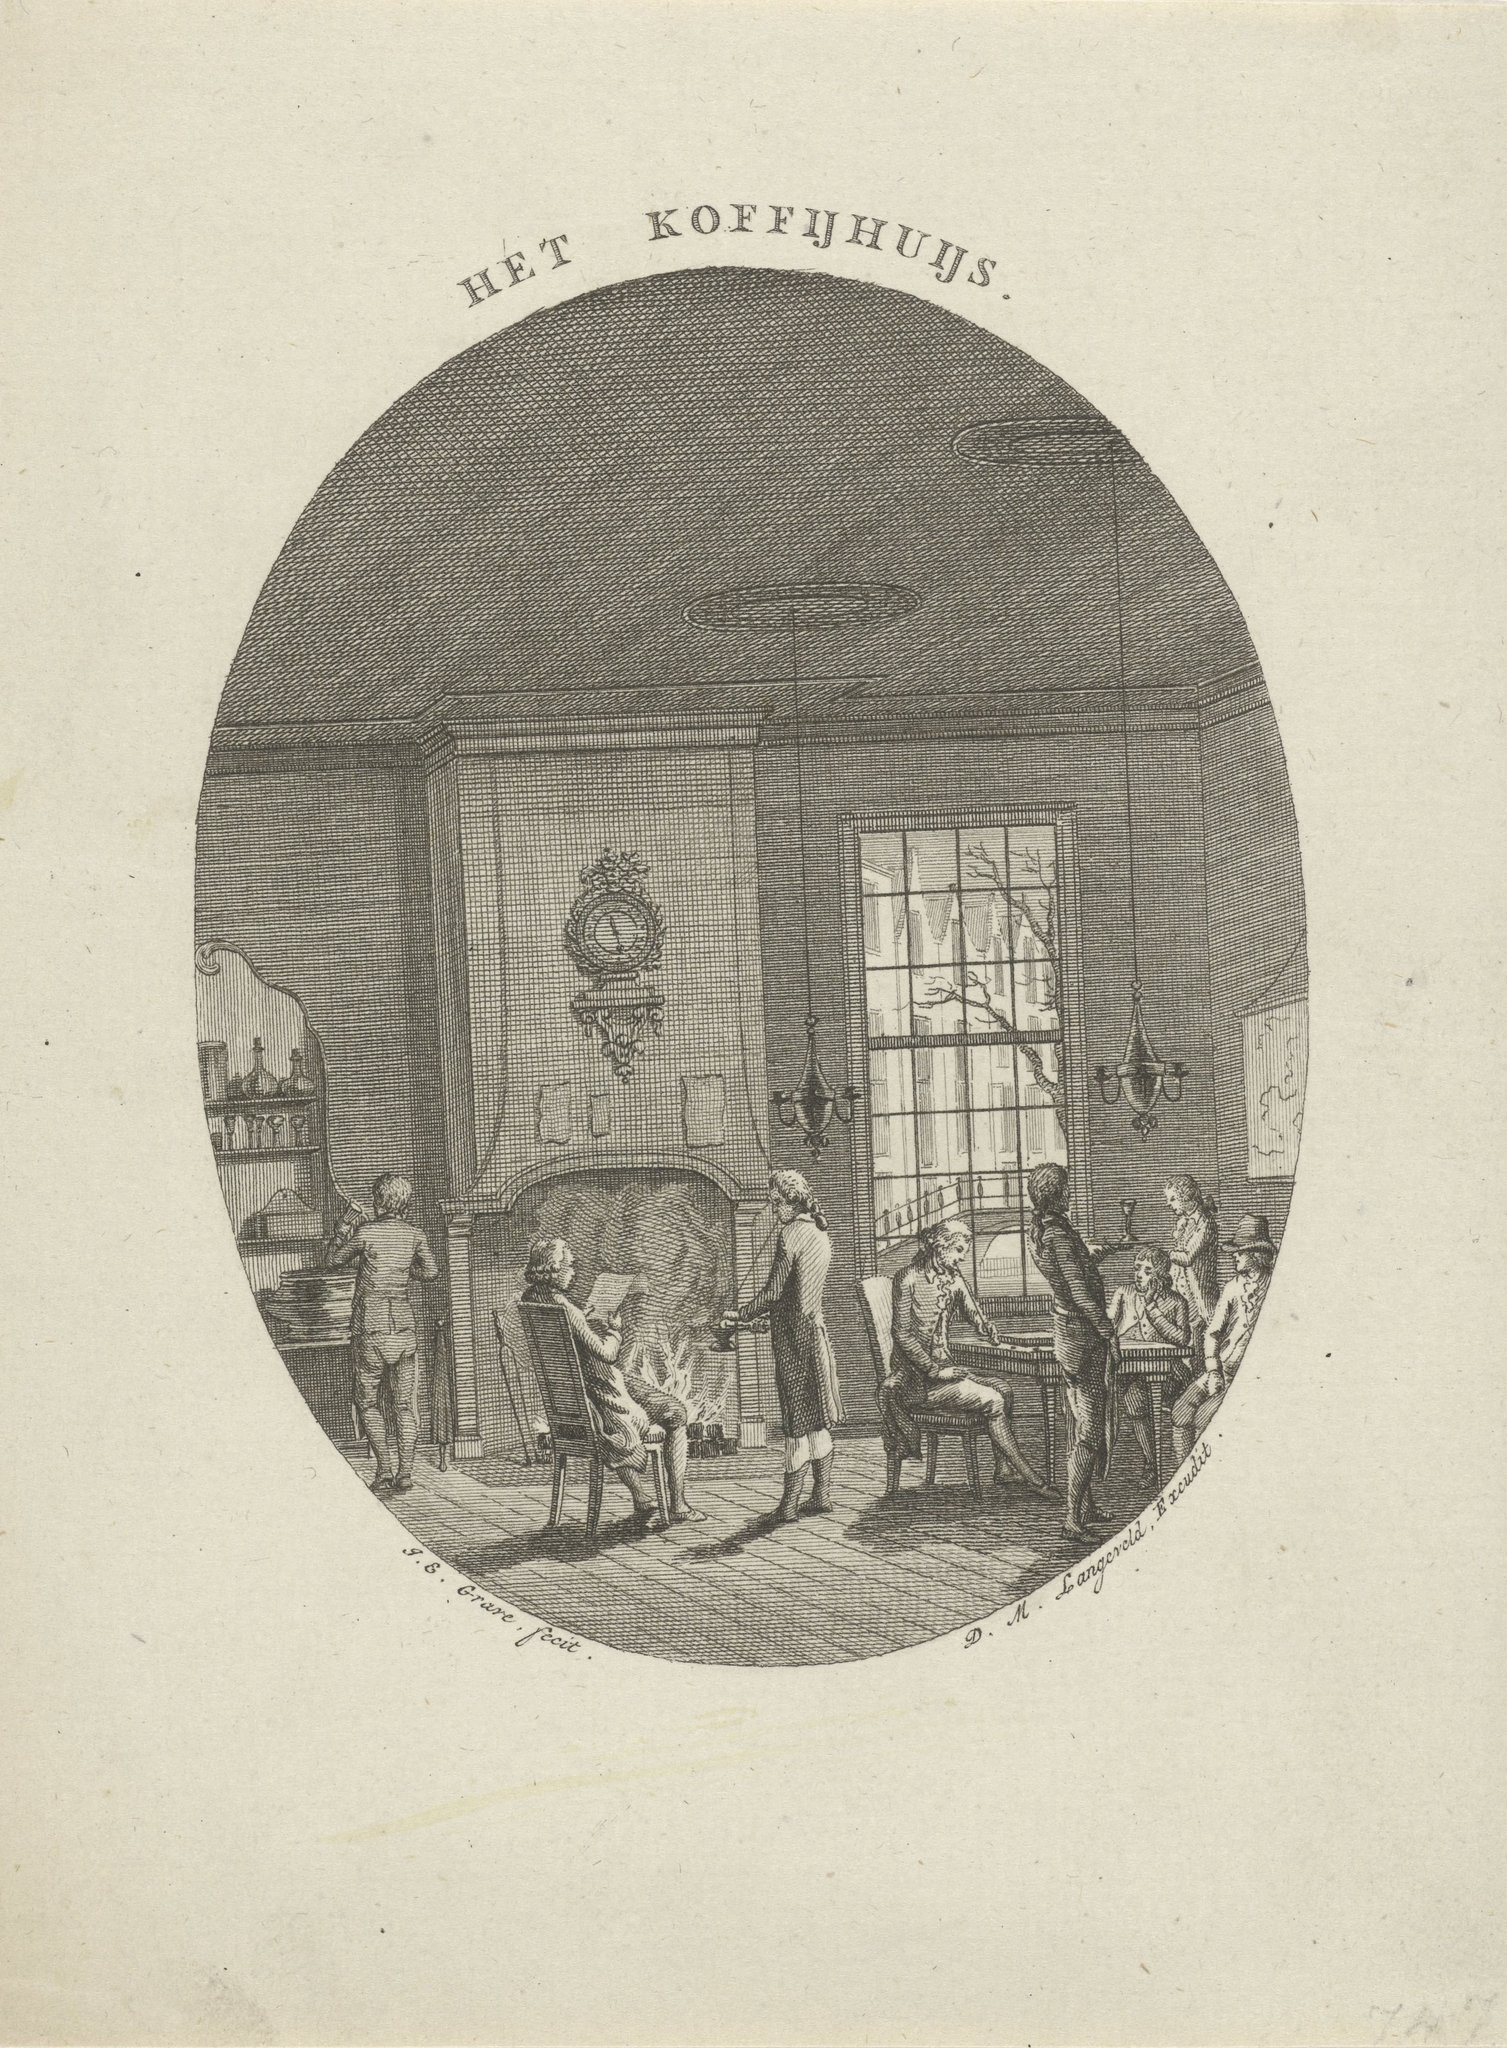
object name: print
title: Het Koffijhuijs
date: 1769-1805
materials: paper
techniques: engraving, etching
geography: amsterdam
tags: inn, coffee-house, public house, etc., pipe ~ tobacco, newspaper, news-sheet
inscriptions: collector's mark: Lugt 2228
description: Het interieur van een koffiehuis in een ovale lijst. In een kamer met open haard staan en zitten verschillende mannen. De mannen roken, lezen de krant of drinken.